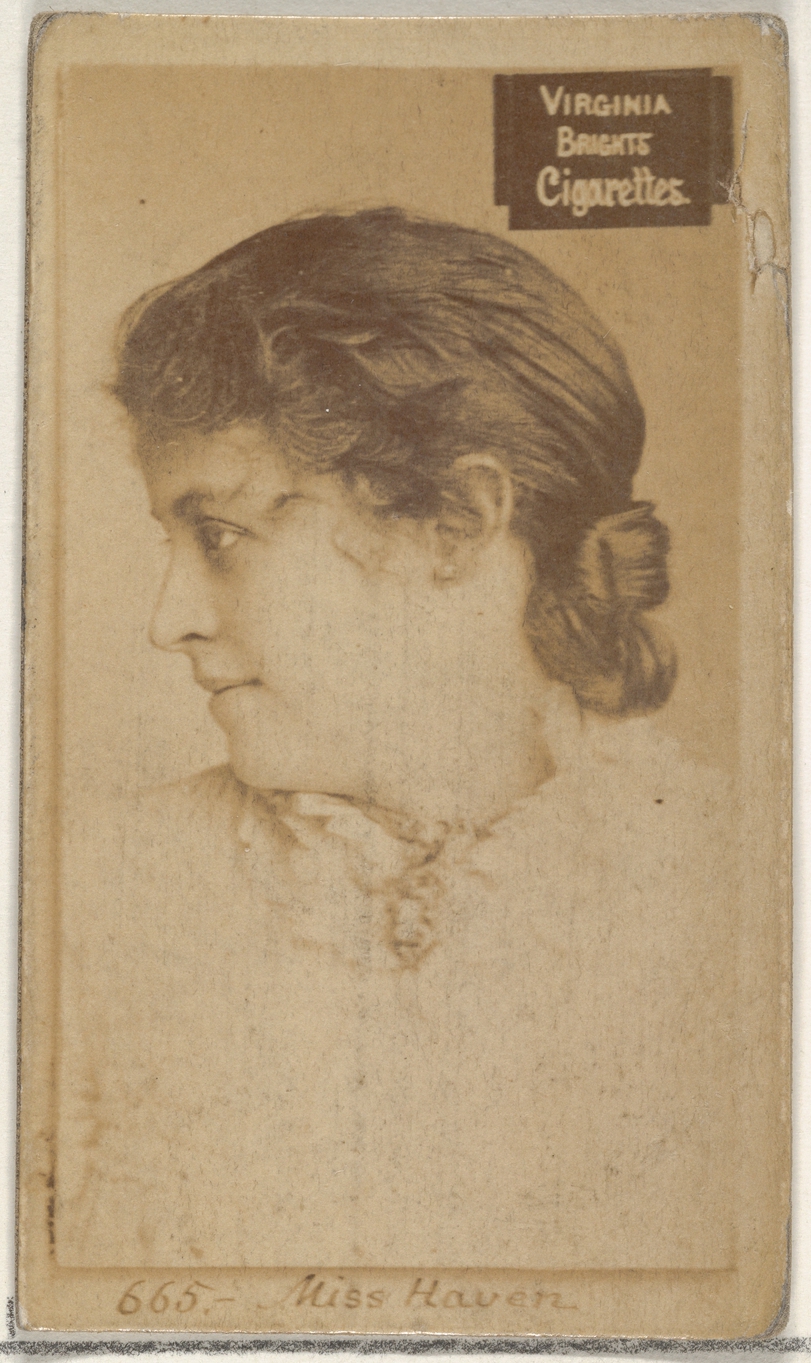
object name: photograph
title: Card 665, Miss Haven, from the Actors and Actresses series (N45, Type 2) for Virginia Brights Cigarettes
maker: allen & ginter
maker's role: publisher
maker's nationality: american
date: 1888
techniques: albumen silver print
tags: portraits,profiles,women,actresses